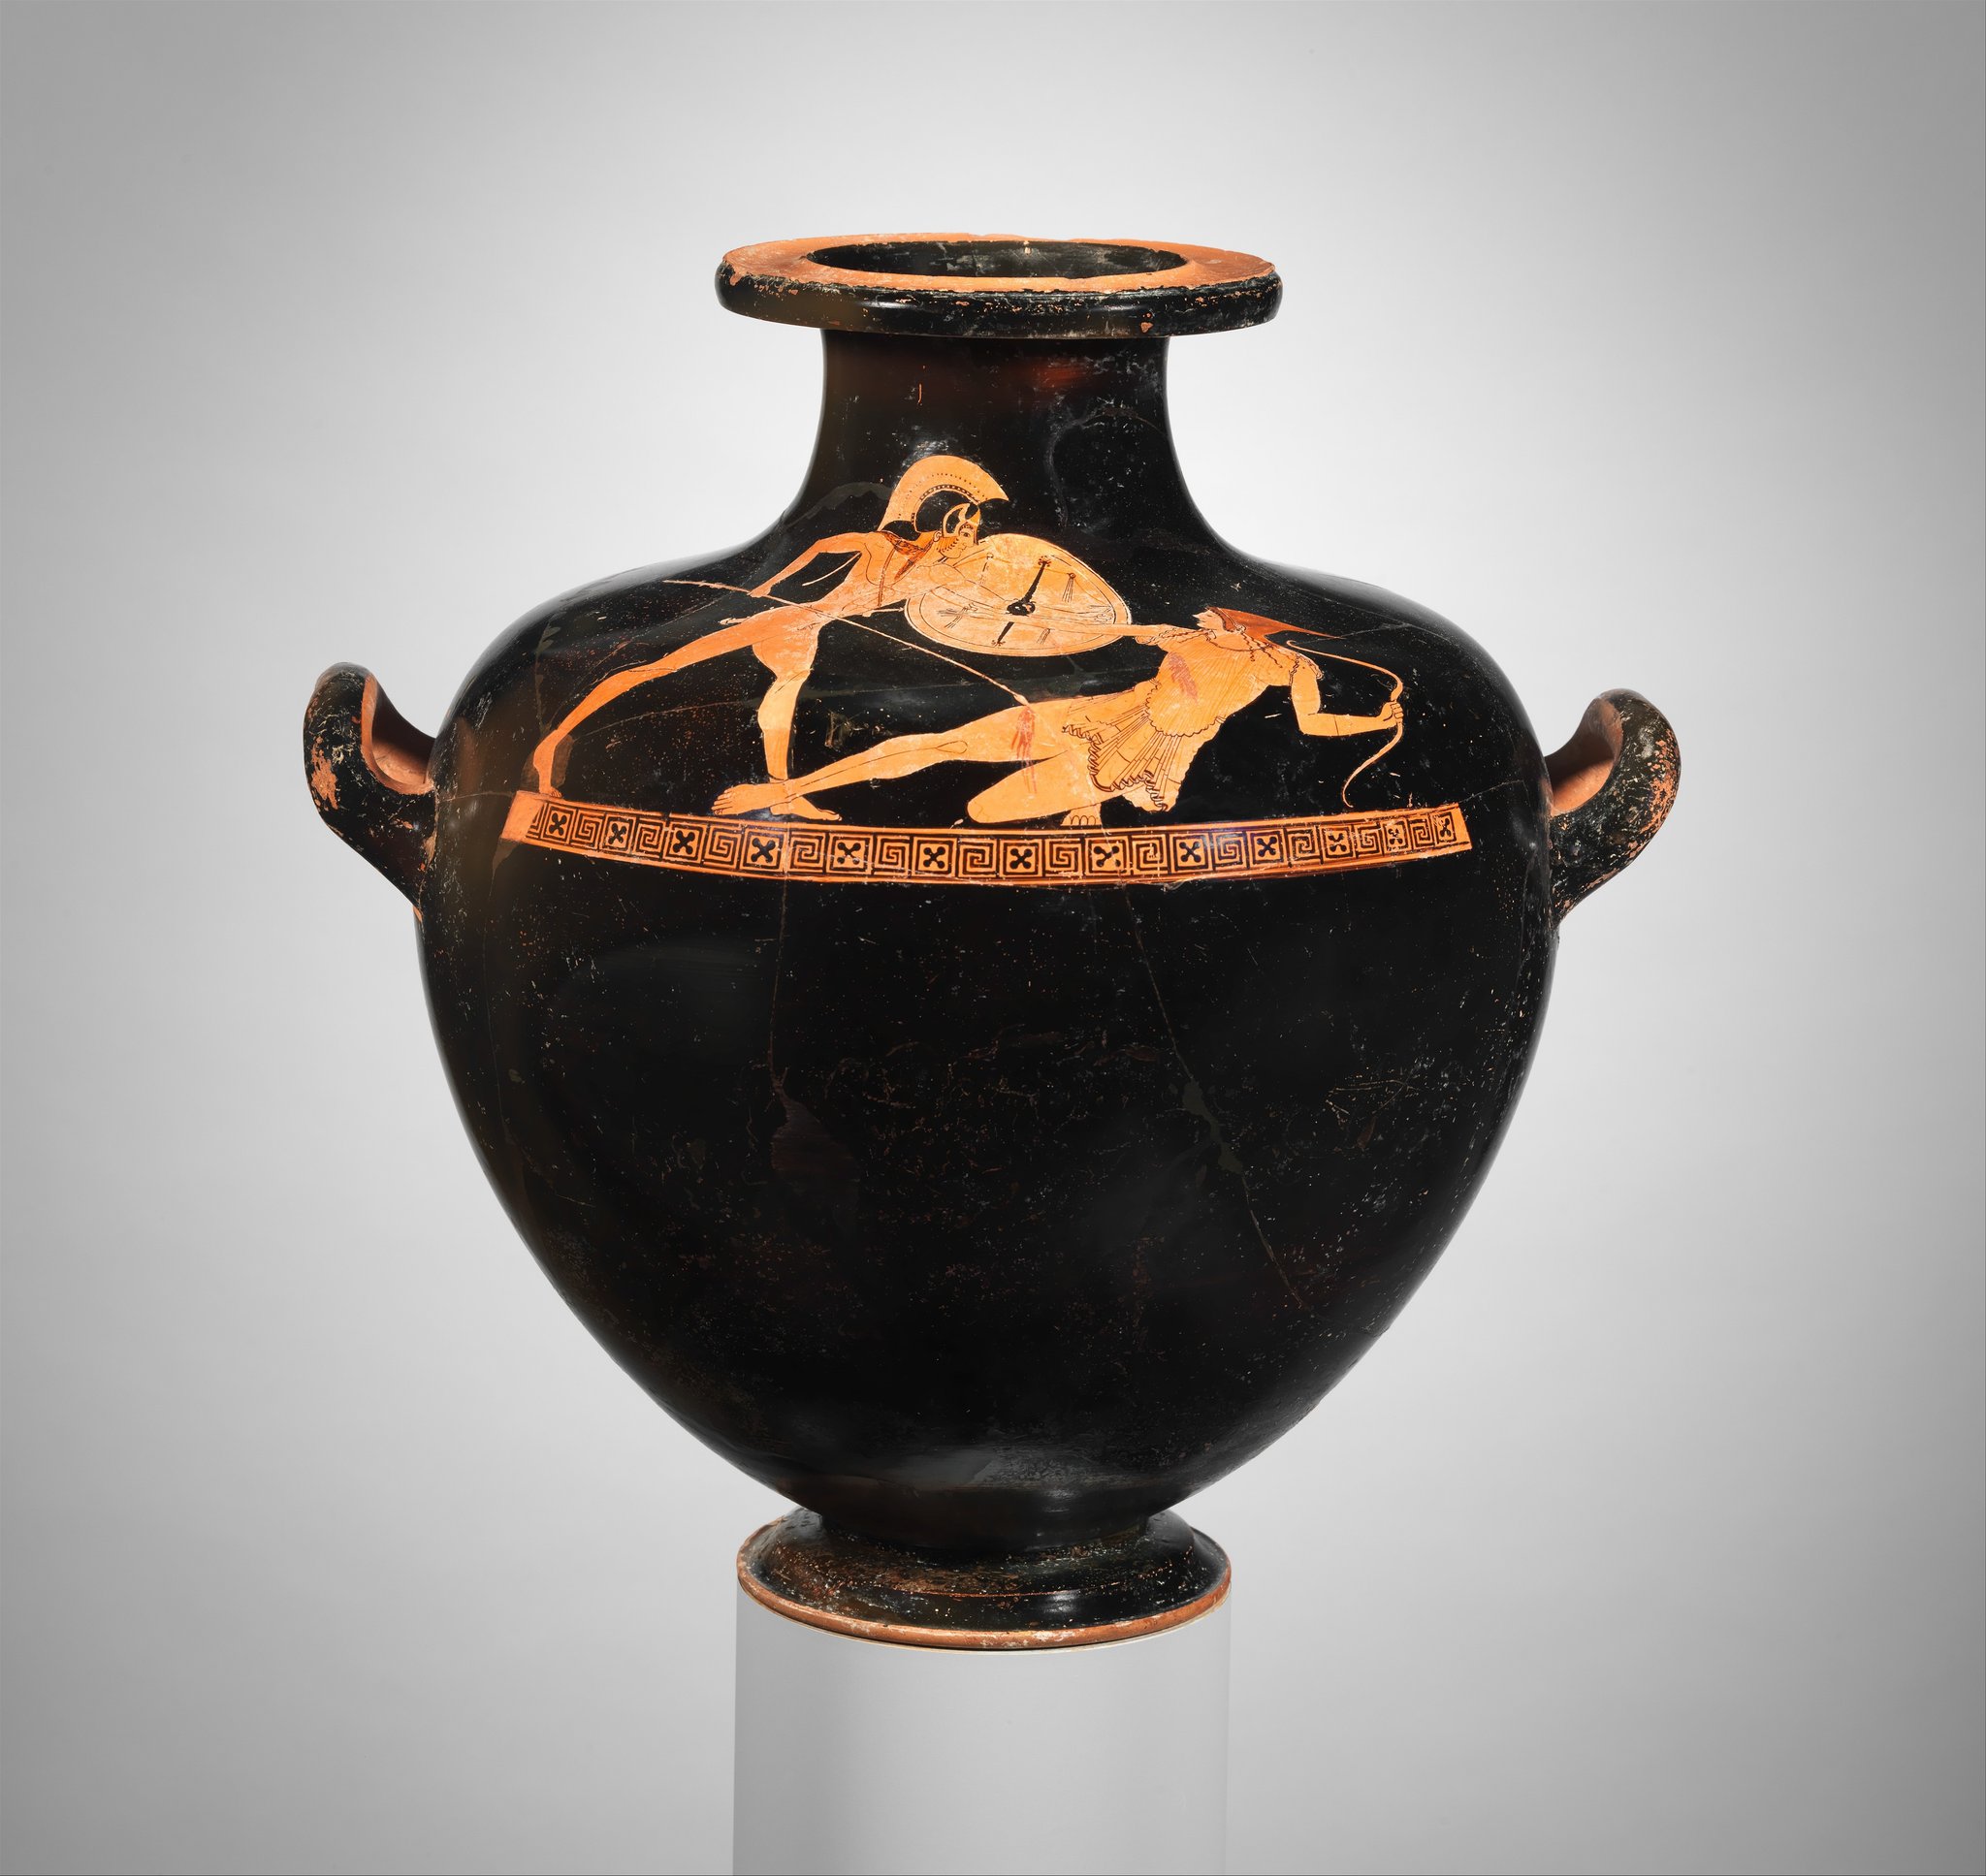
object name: hydria, kalpis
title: Terracotta hydria: kalpis (water jar)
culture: greek, attic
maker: berlin painter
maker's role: artist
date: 500 BCE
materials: terracotta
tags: shields,achilles,amazons